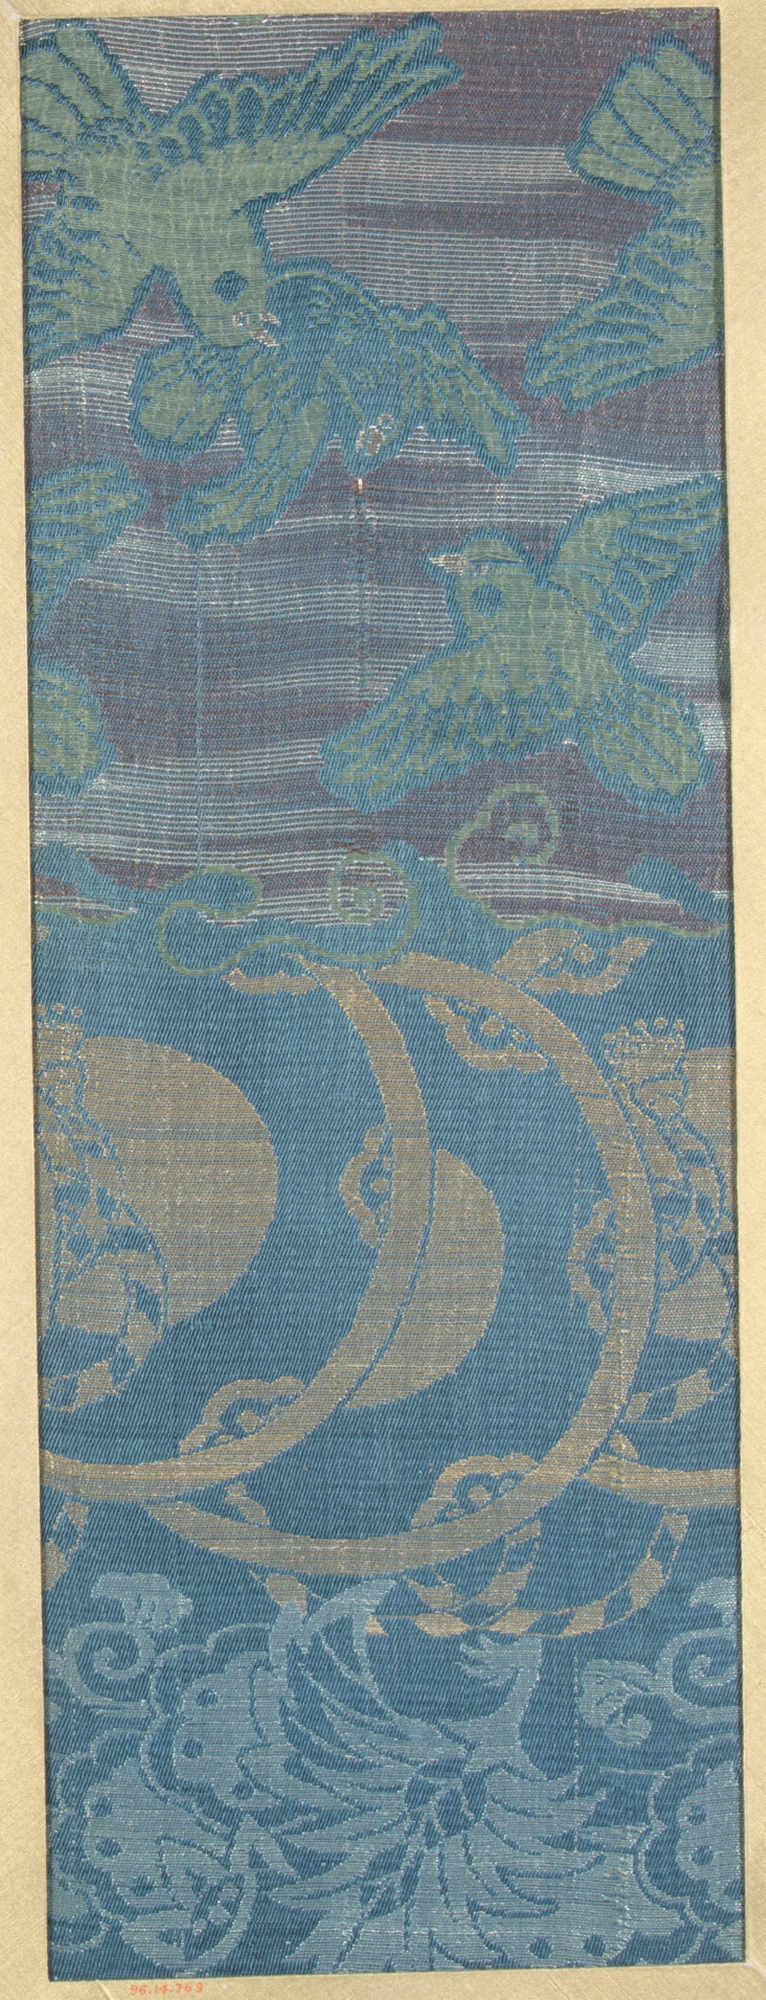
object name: piece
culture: japanese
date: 1701-1900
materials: silk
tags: birds